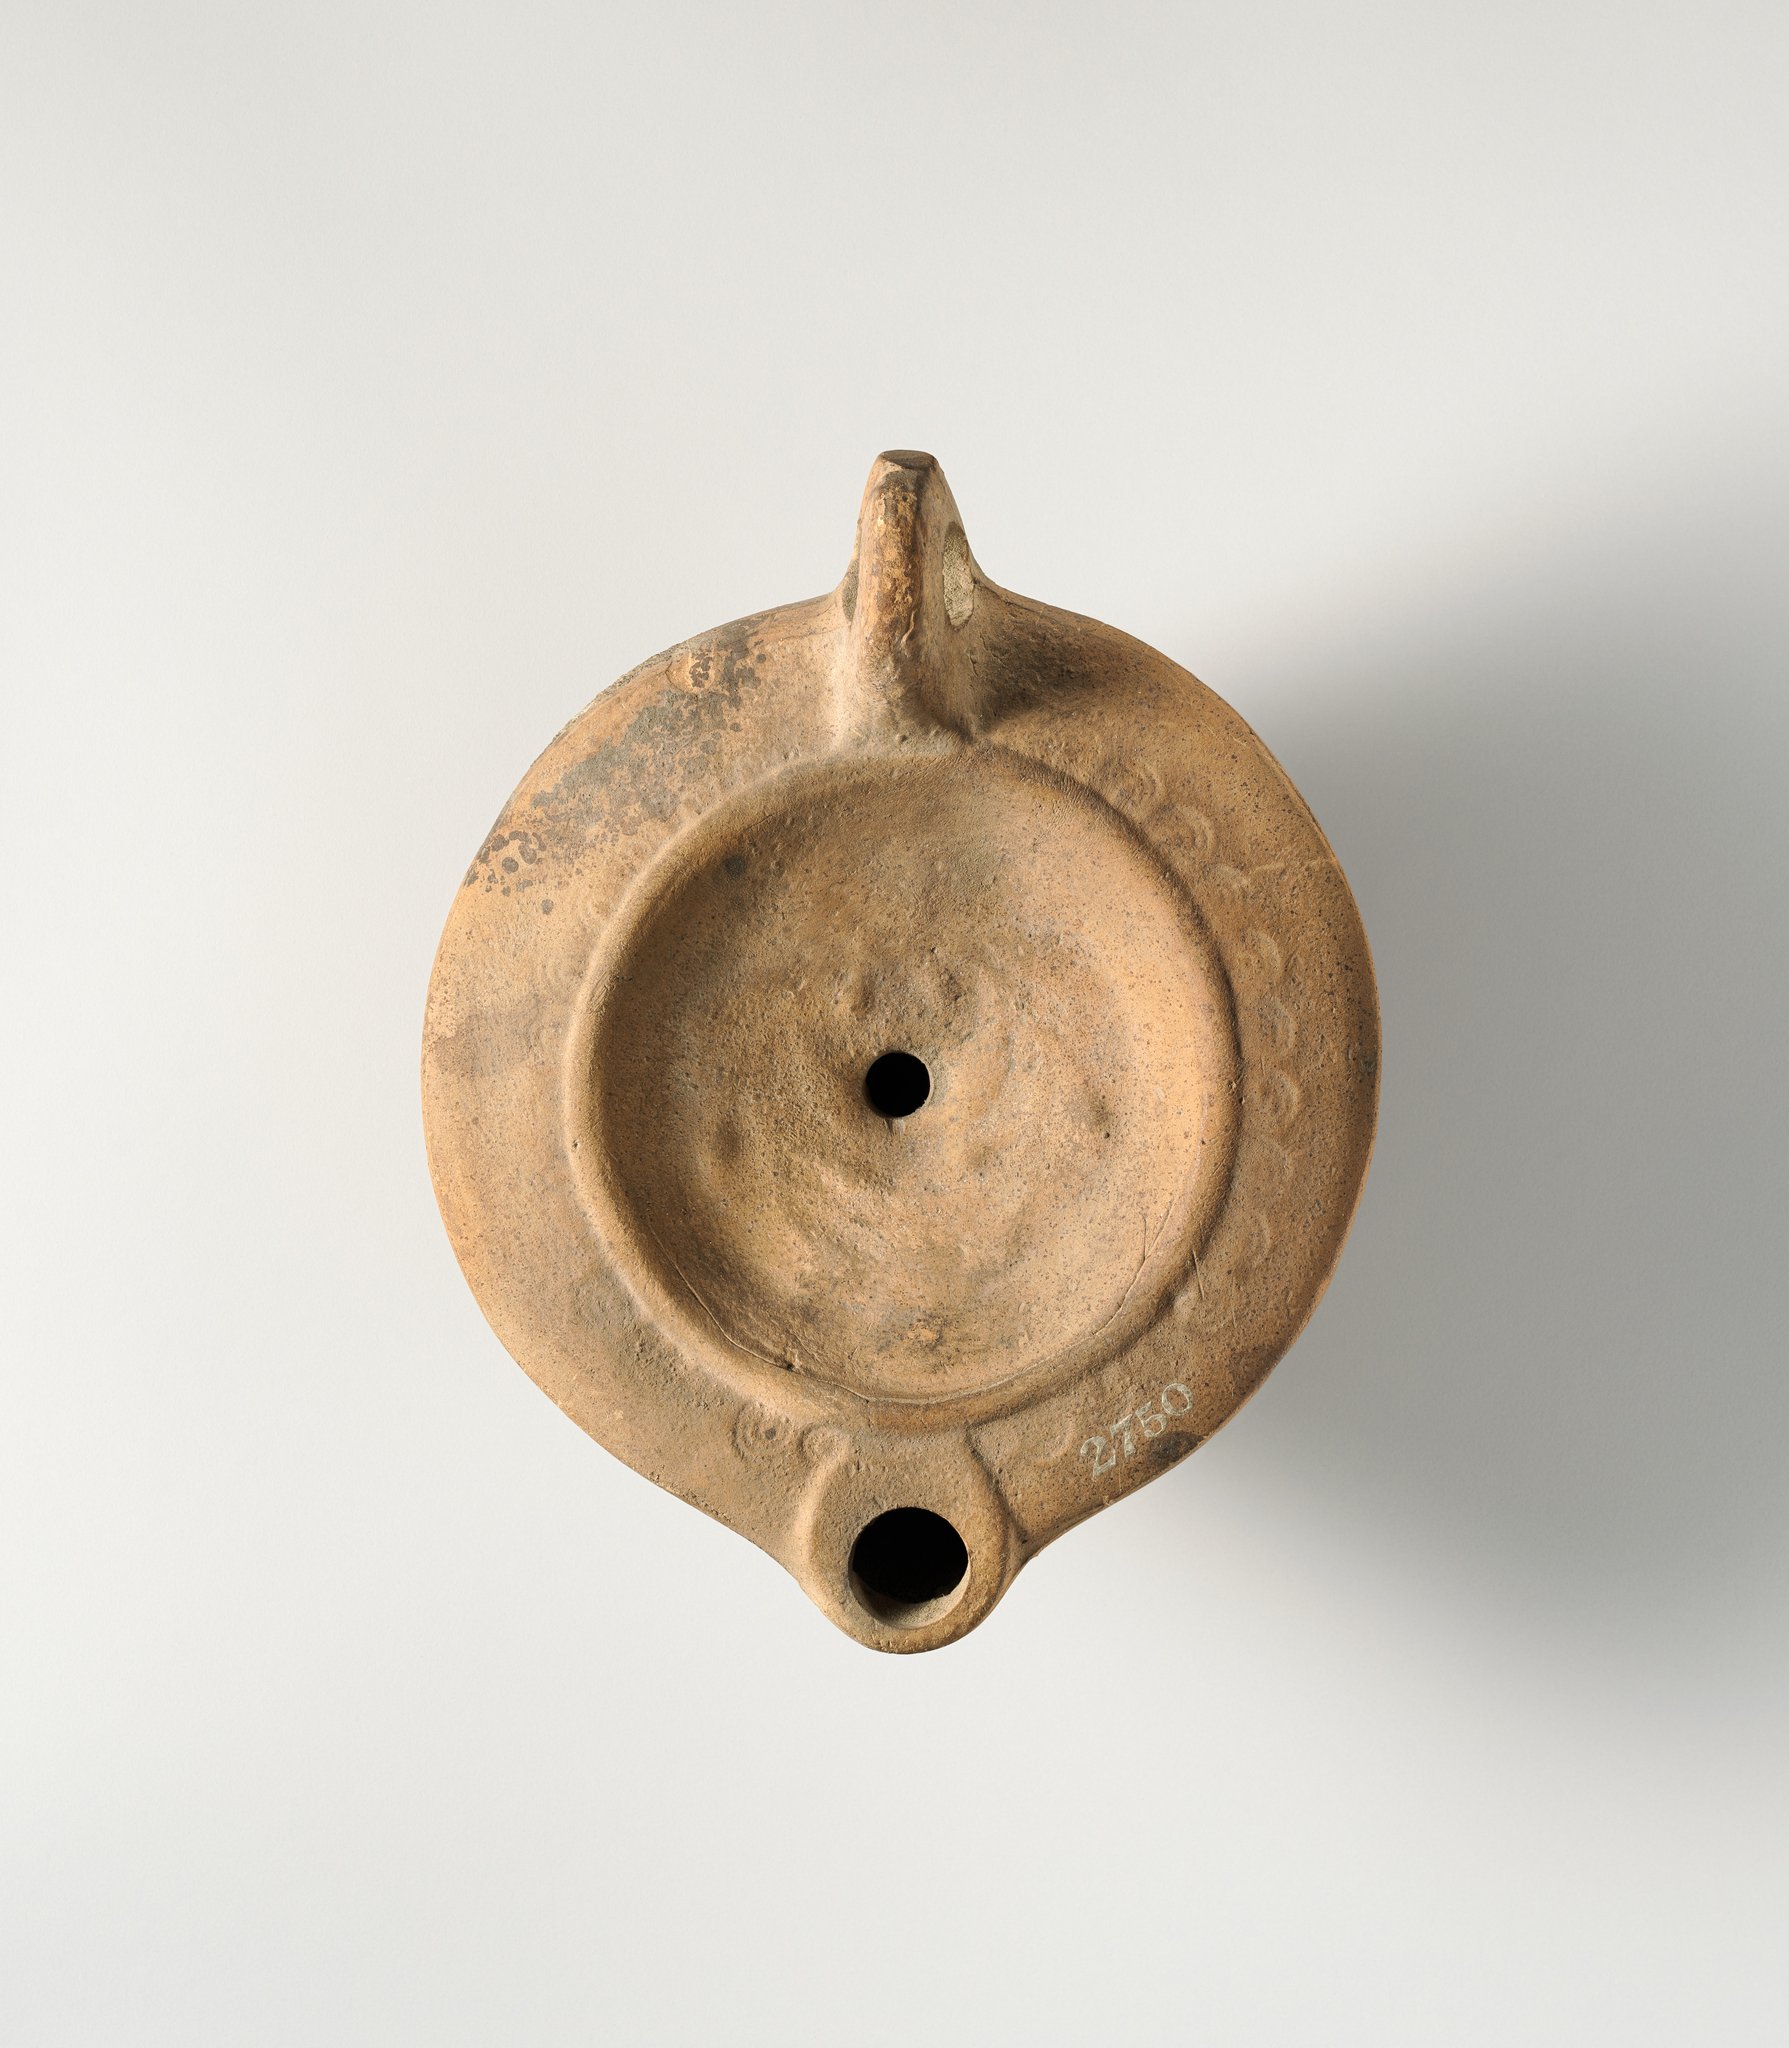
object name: lamp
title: Terracotta oil lamp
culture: roman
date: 101-200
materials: terracotta